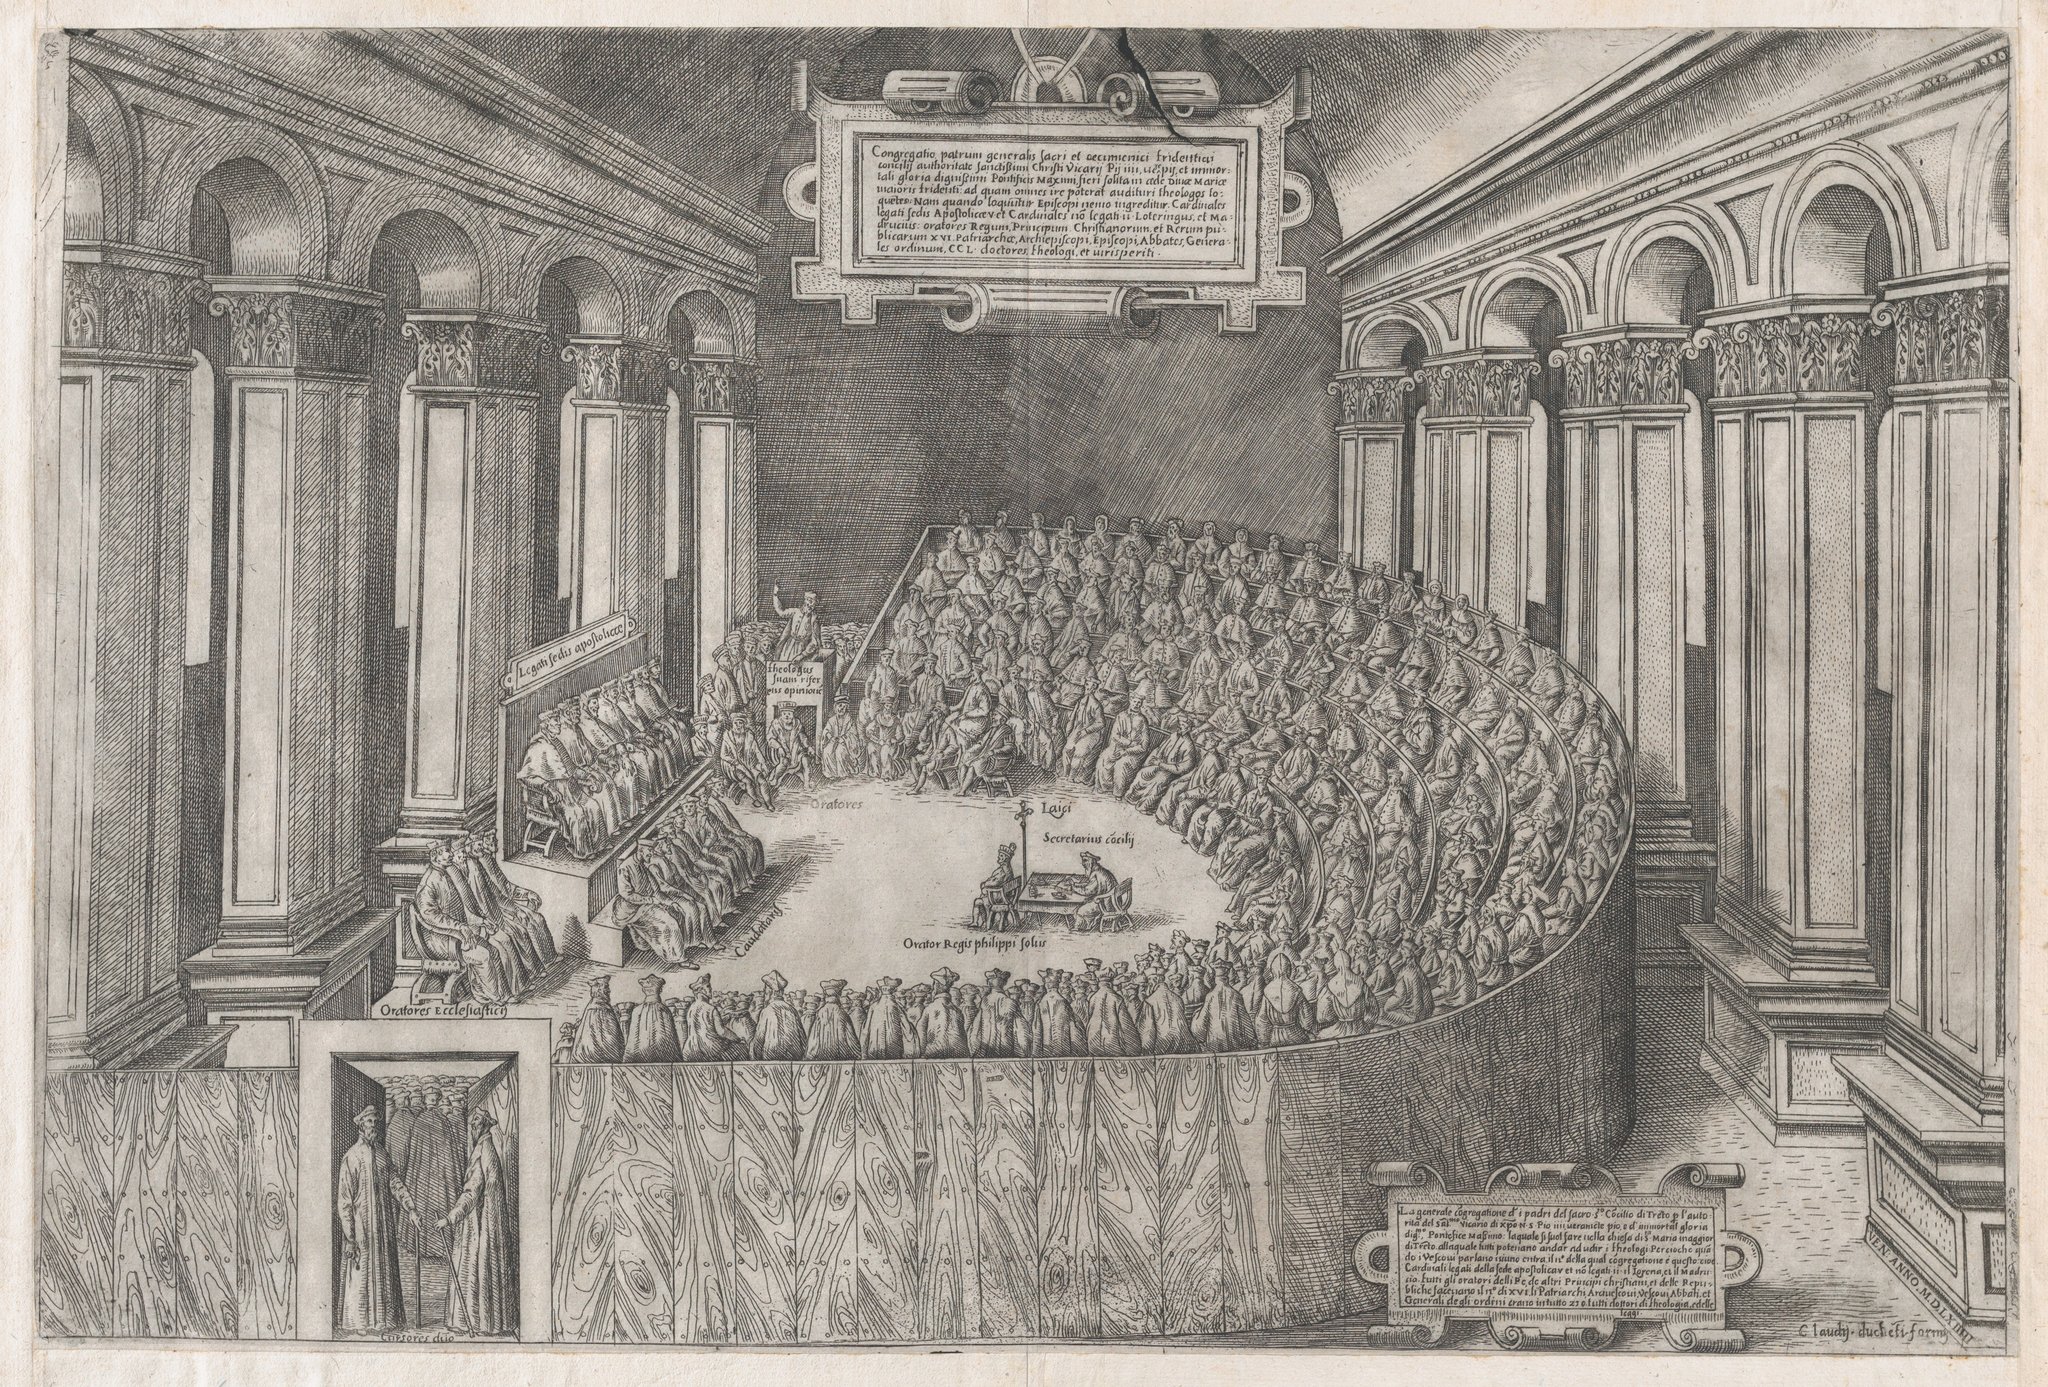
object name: print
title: Council of Trent, from "Speculum Romanae Magnificentiae"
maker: anonymous, italian, 16th century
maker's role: artist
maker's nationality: italian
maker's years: 1500-1600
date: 1565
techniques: engraving, etching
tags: interiors,men